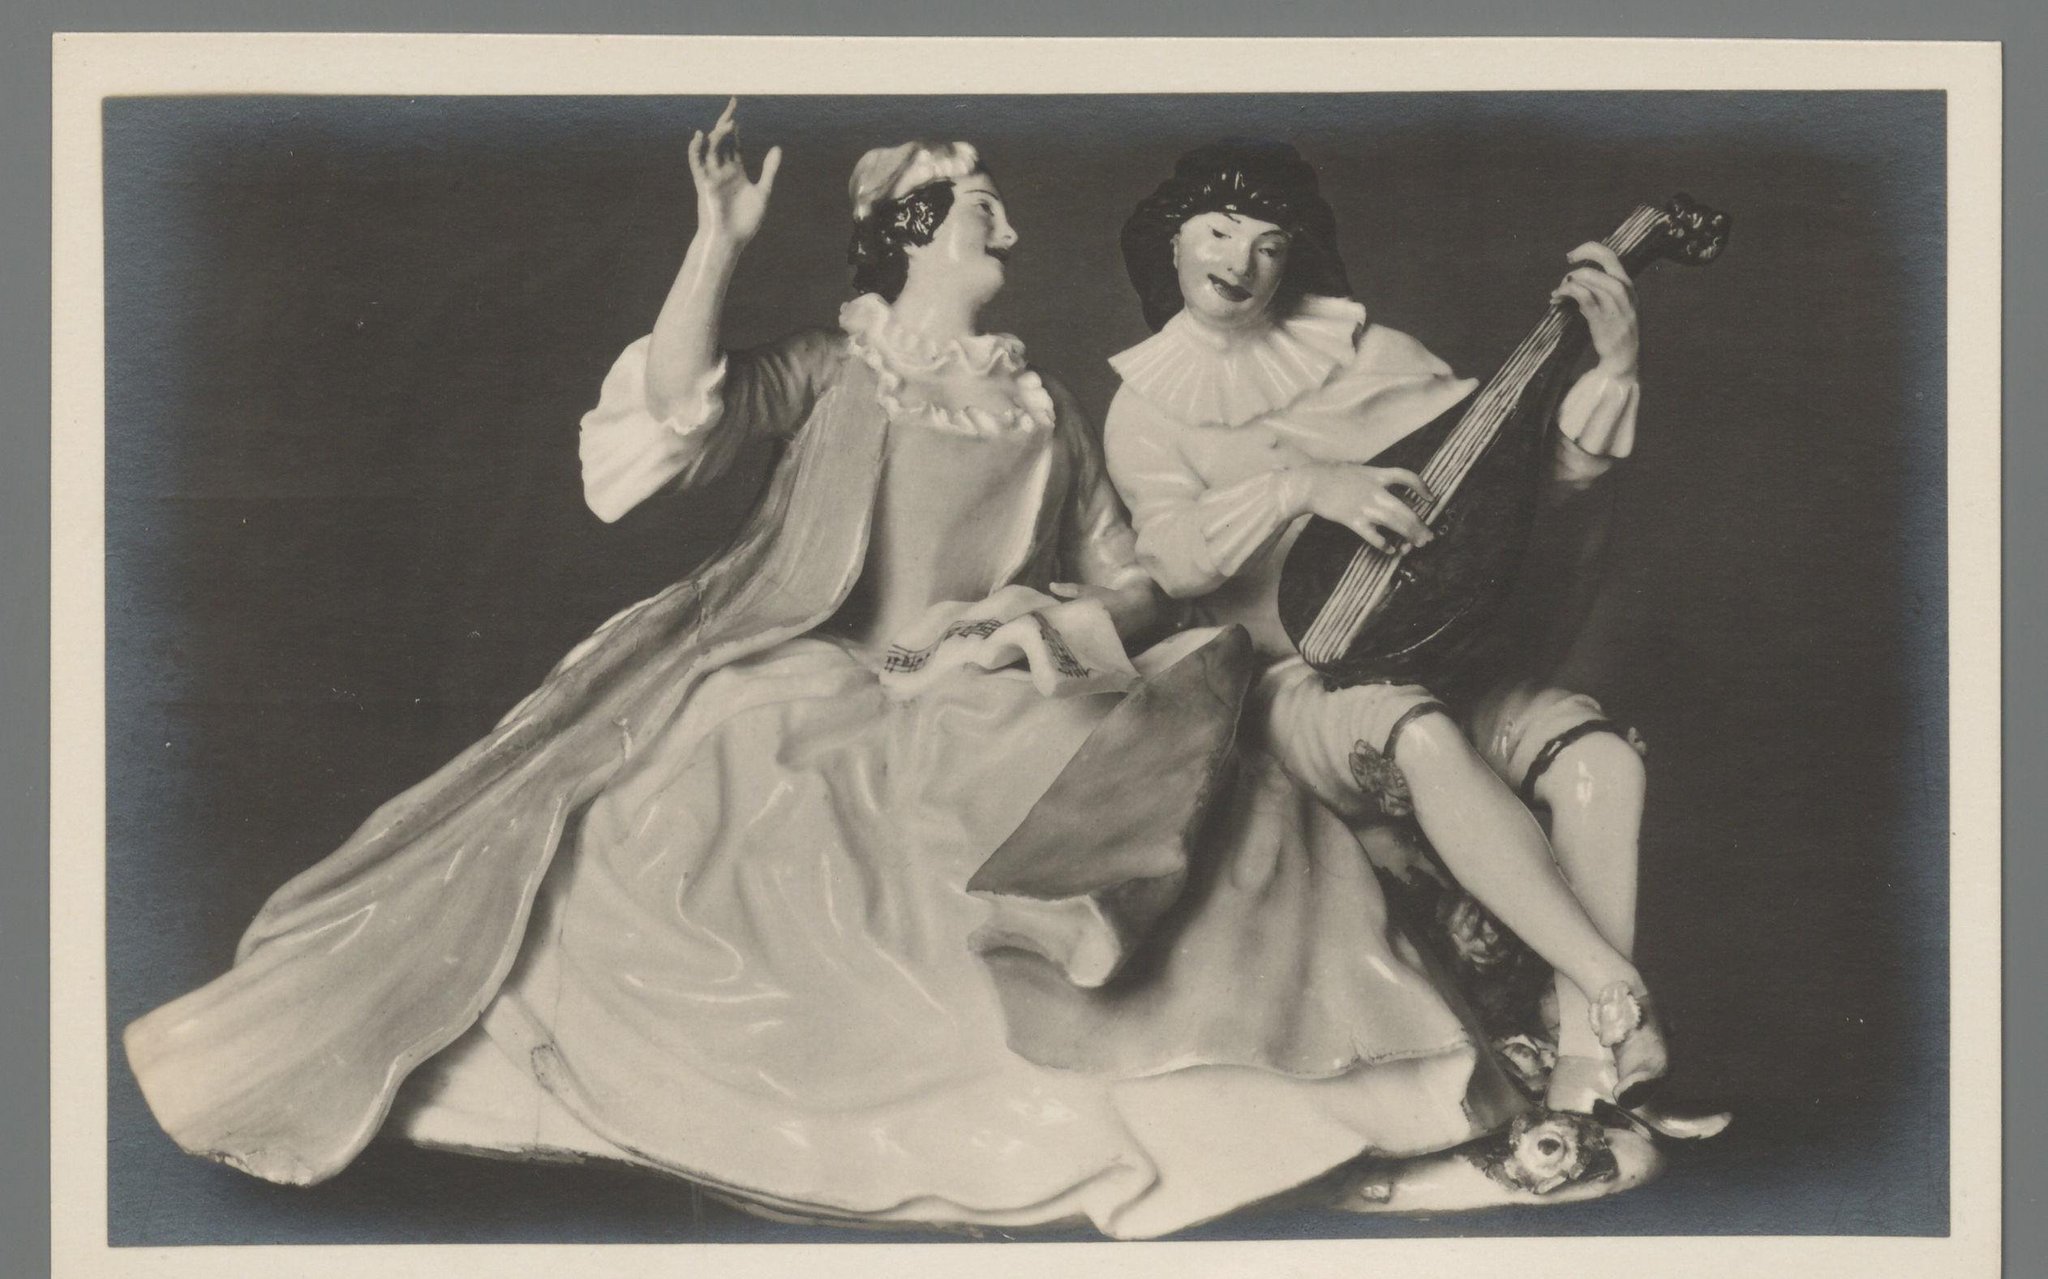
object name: ansichtkaart, prentbriefkaart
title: Schlossmuseum Berlin. Joachim Kändler: Komödiengruppe. Meissener Porzellan 1761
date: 1918-1930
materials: photographic support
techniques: photography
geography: berlin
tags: castle, statues, paintings, etc. ~ objects of worship in roman religion, permanent exhibition, museum